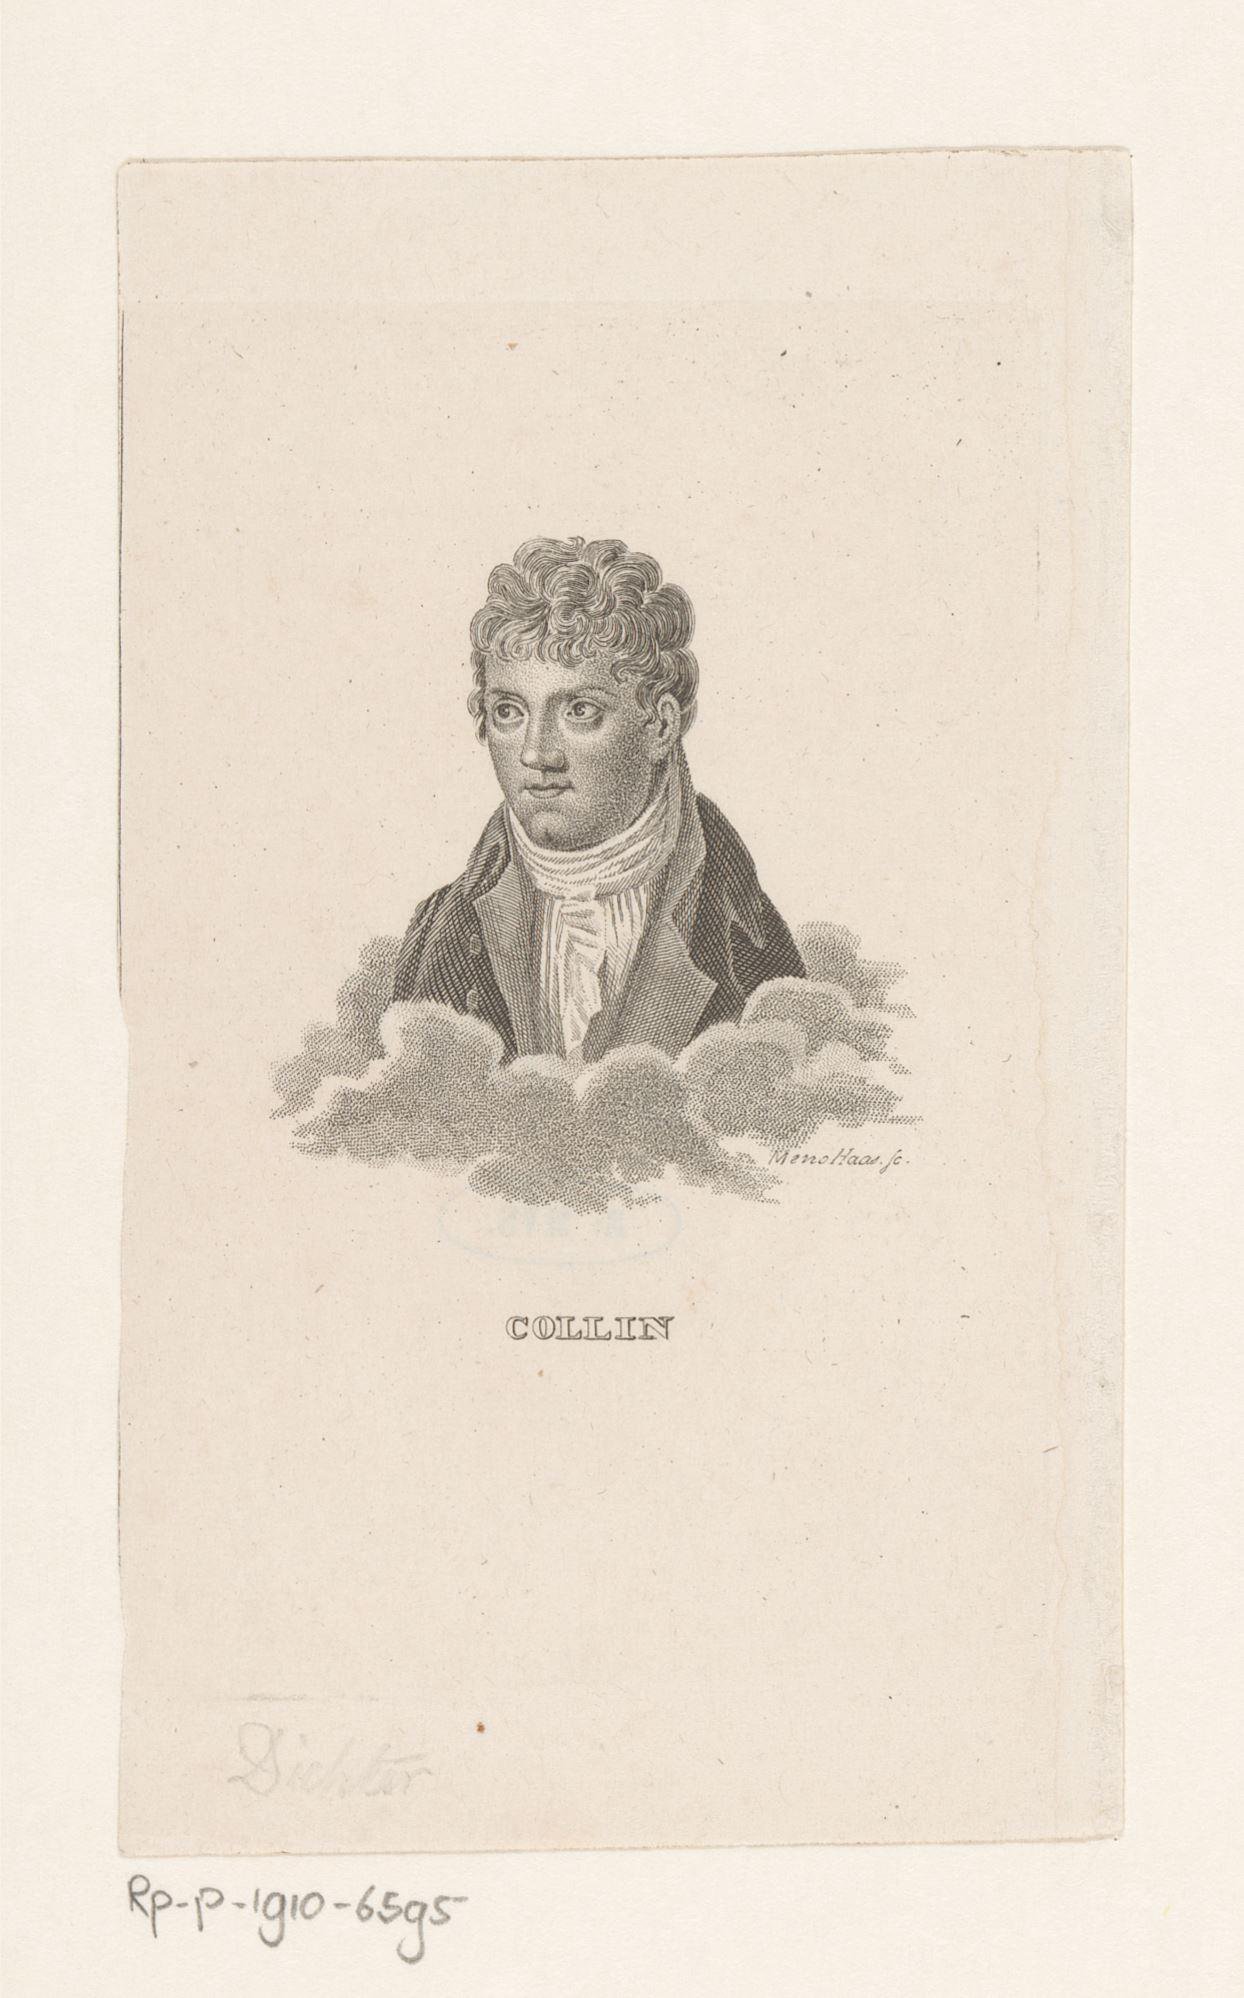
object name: print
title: Portret van Matthäus von Collin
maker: meno haas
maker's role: print maker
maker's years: 1752-1833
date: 1824-1833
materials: paper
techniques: engraving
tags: clouds, historical persons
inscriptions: collector's mark: Lugt 2228